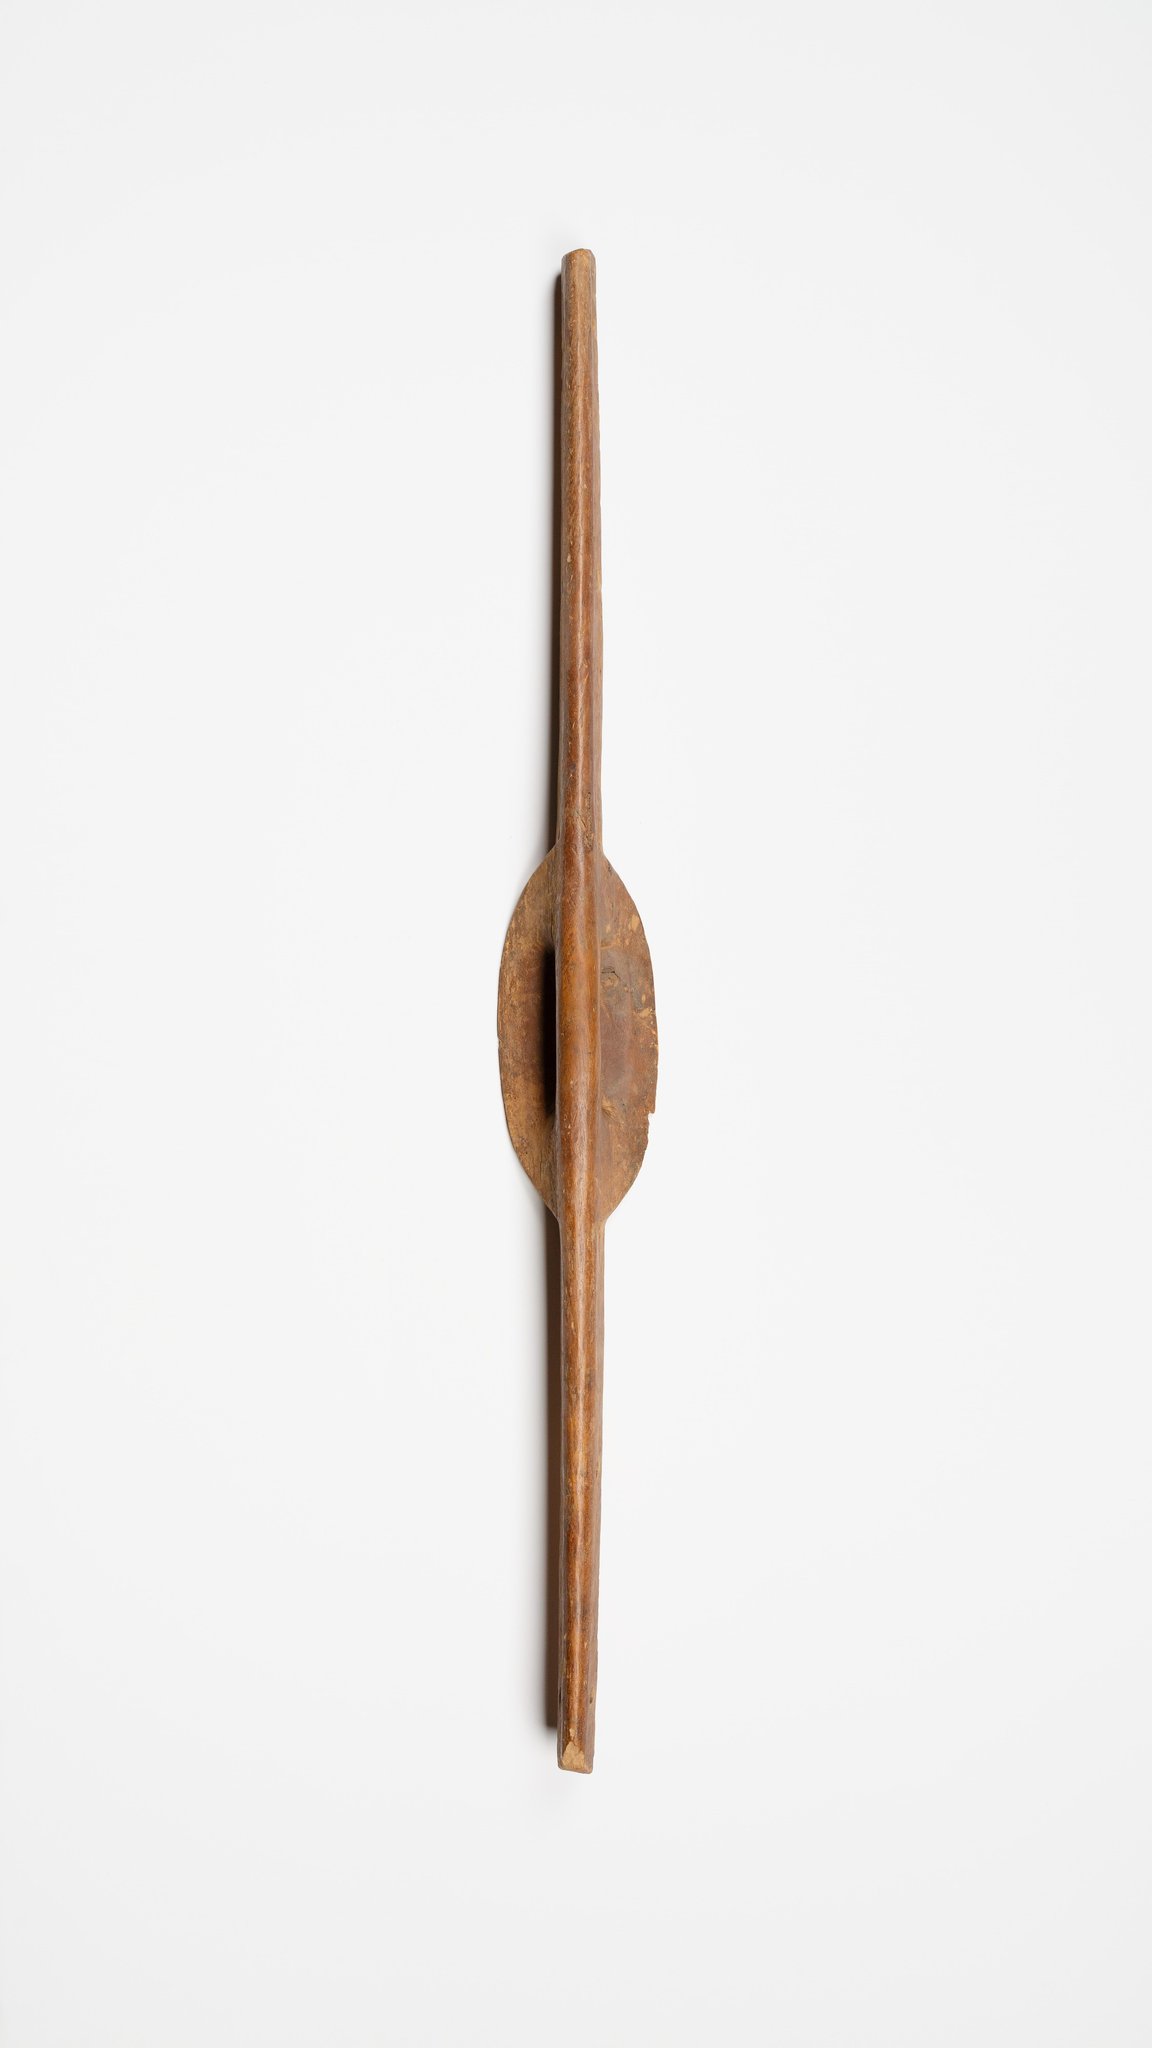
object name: shield handle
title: Handle of a Shield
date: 1981-1550 BCE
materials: wood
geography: egypt